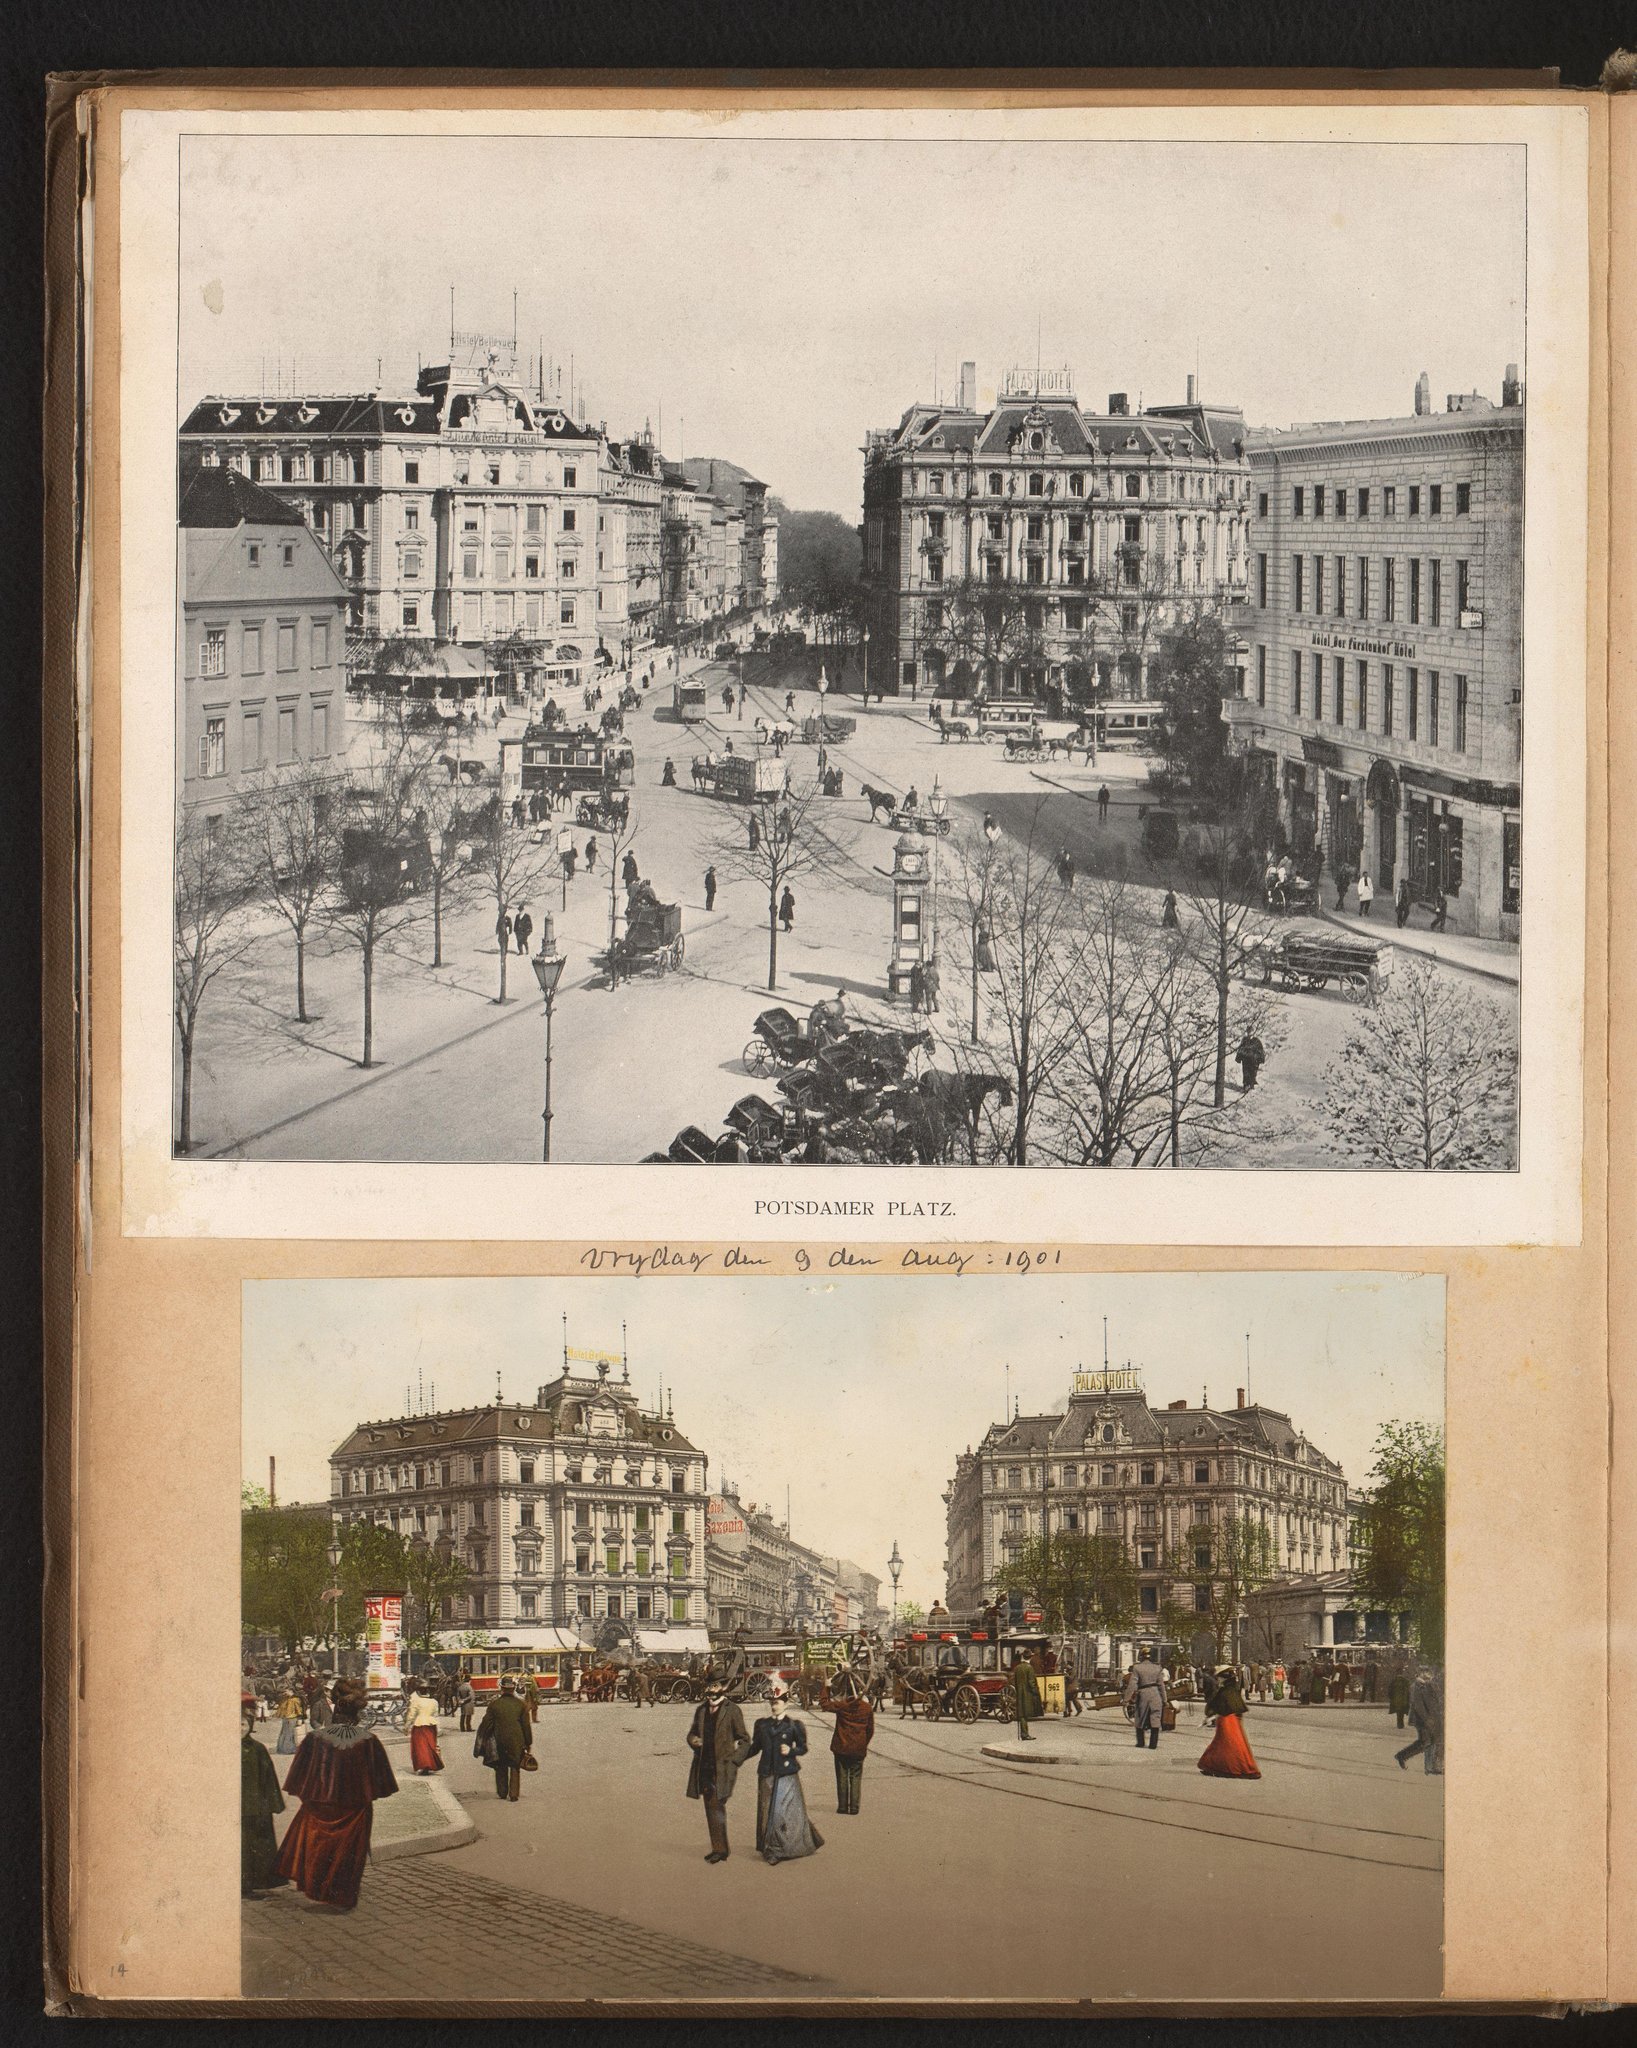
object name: album leaf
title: Twee gezichten op de Potsdamer Platz, Berlijn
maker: Anonymous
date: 1896-1901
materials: paper, photographic process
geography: zurich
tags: square, place, circus, etc.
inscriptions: title: ‘Potsdamer Platz’, inscription: ‘Vrijdag den 9den Aug: 1901’, inscription: ‘16517. P.Z. - Berlin. Am Potsdamer-Platz.’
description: Deze fotomechanische afdrukken maken deel uit van een album.